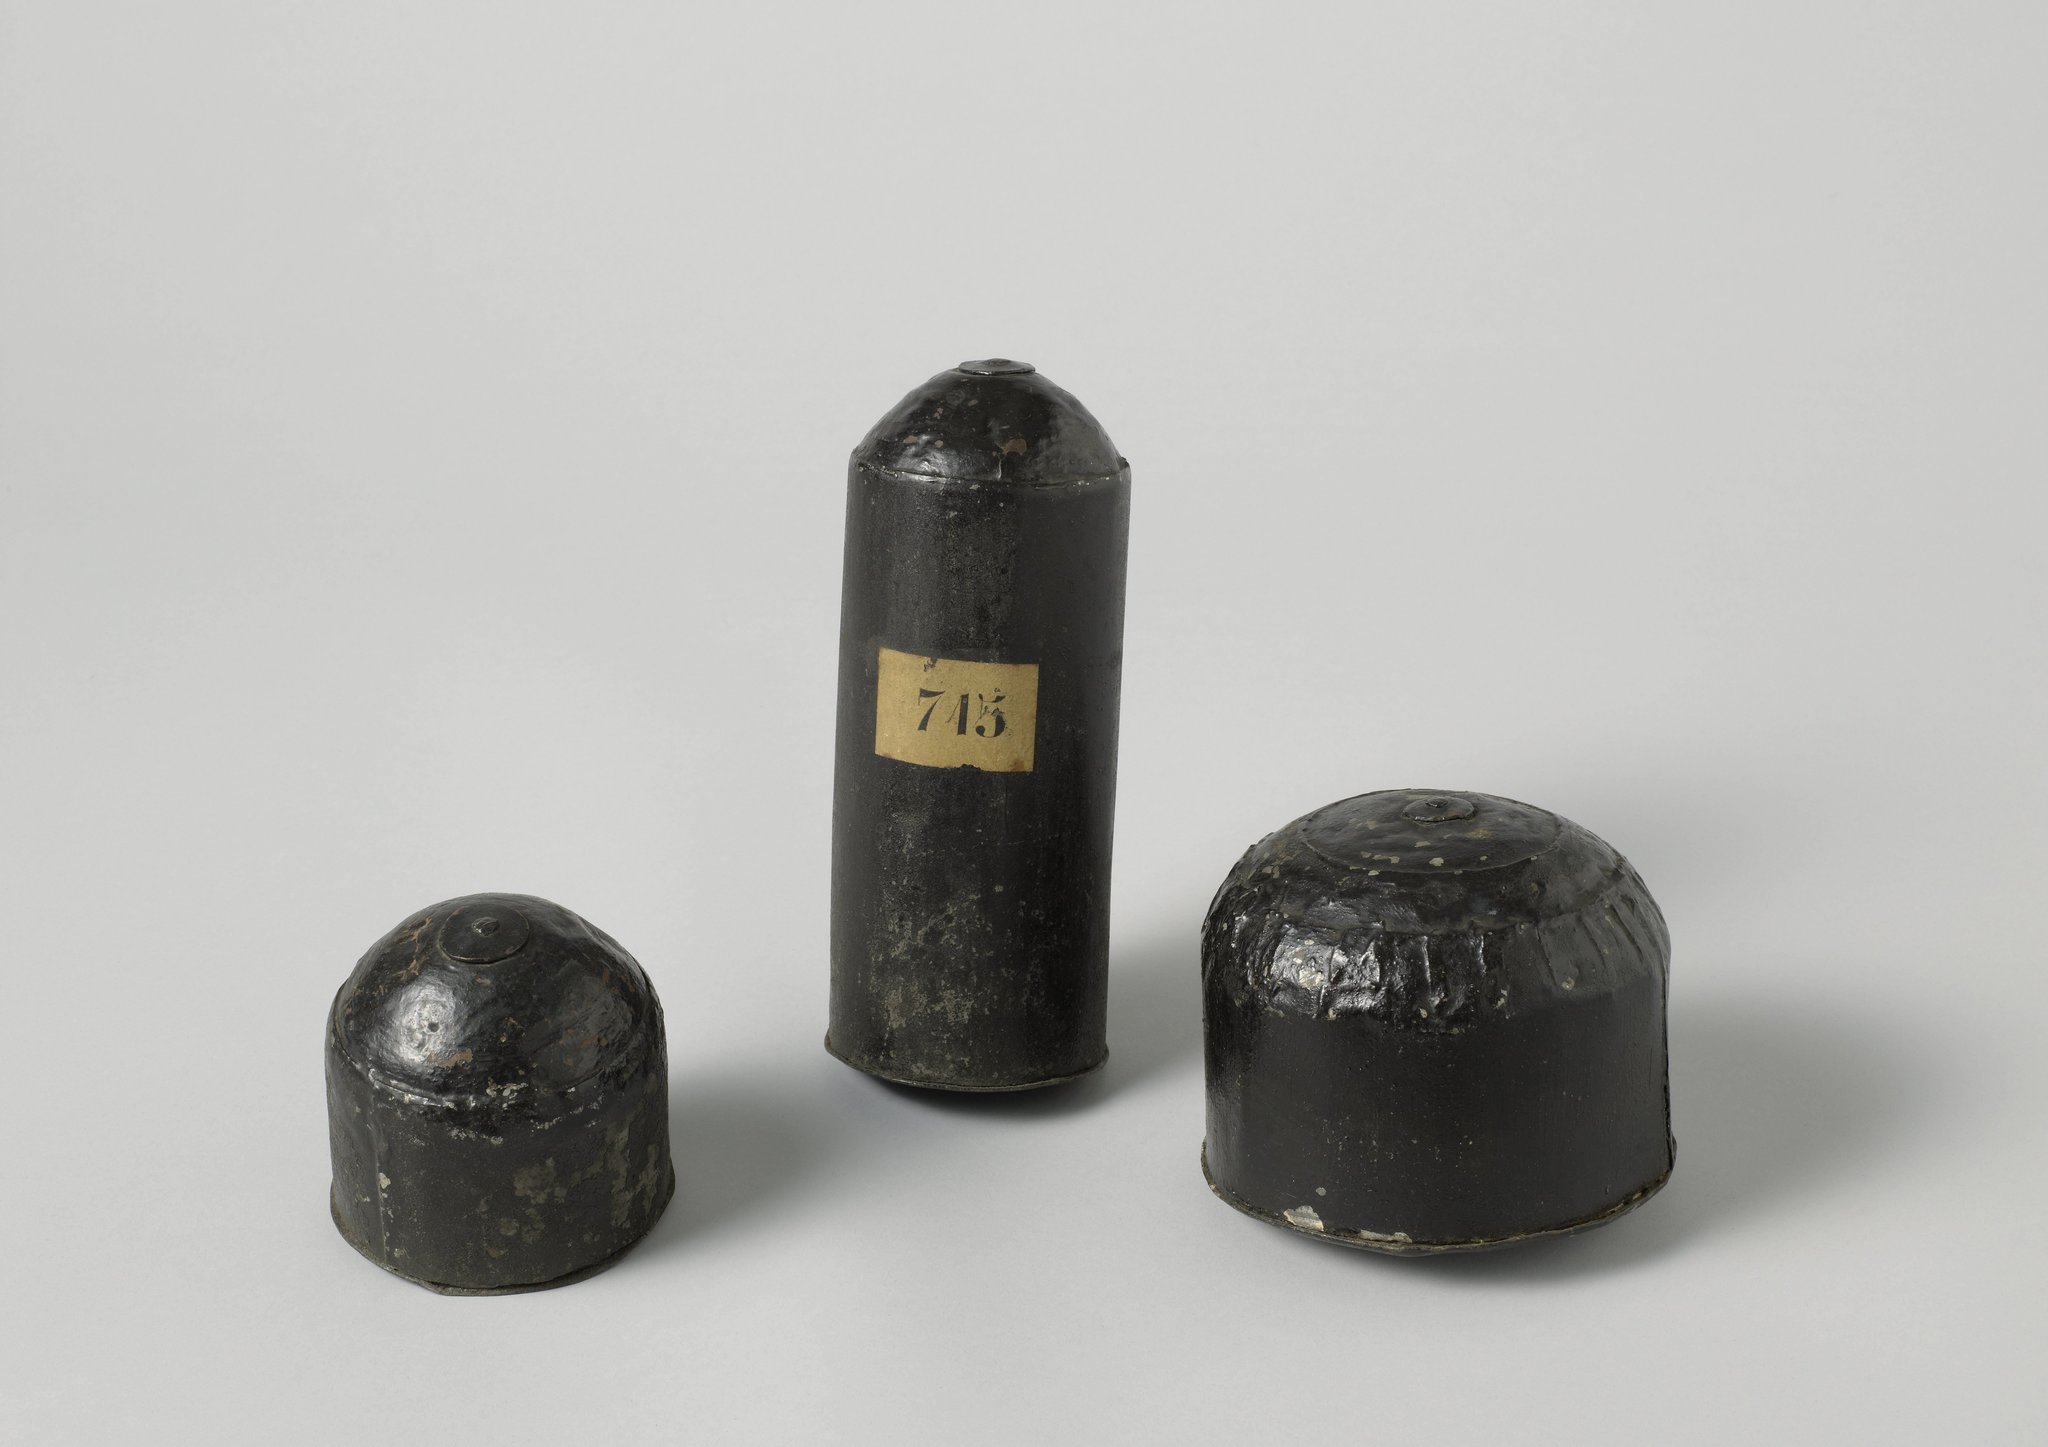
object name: cartridge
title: Model of a Metal Cartridge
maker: h.j. hugenholz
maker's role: luitenant-ter-zee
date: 1832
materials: copper, paint, metal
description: Hugenholz's kardoezen zijn in Nederland nooit aangenomen, voornamelijk omdat men vreesde dat de resten die in de loop zouden achterblijven moeilijk te verwijderen zouden zijn, en omdat zij onderhevig waren aan roest en niet voldoende bescherming tegen vocht konden bieden.